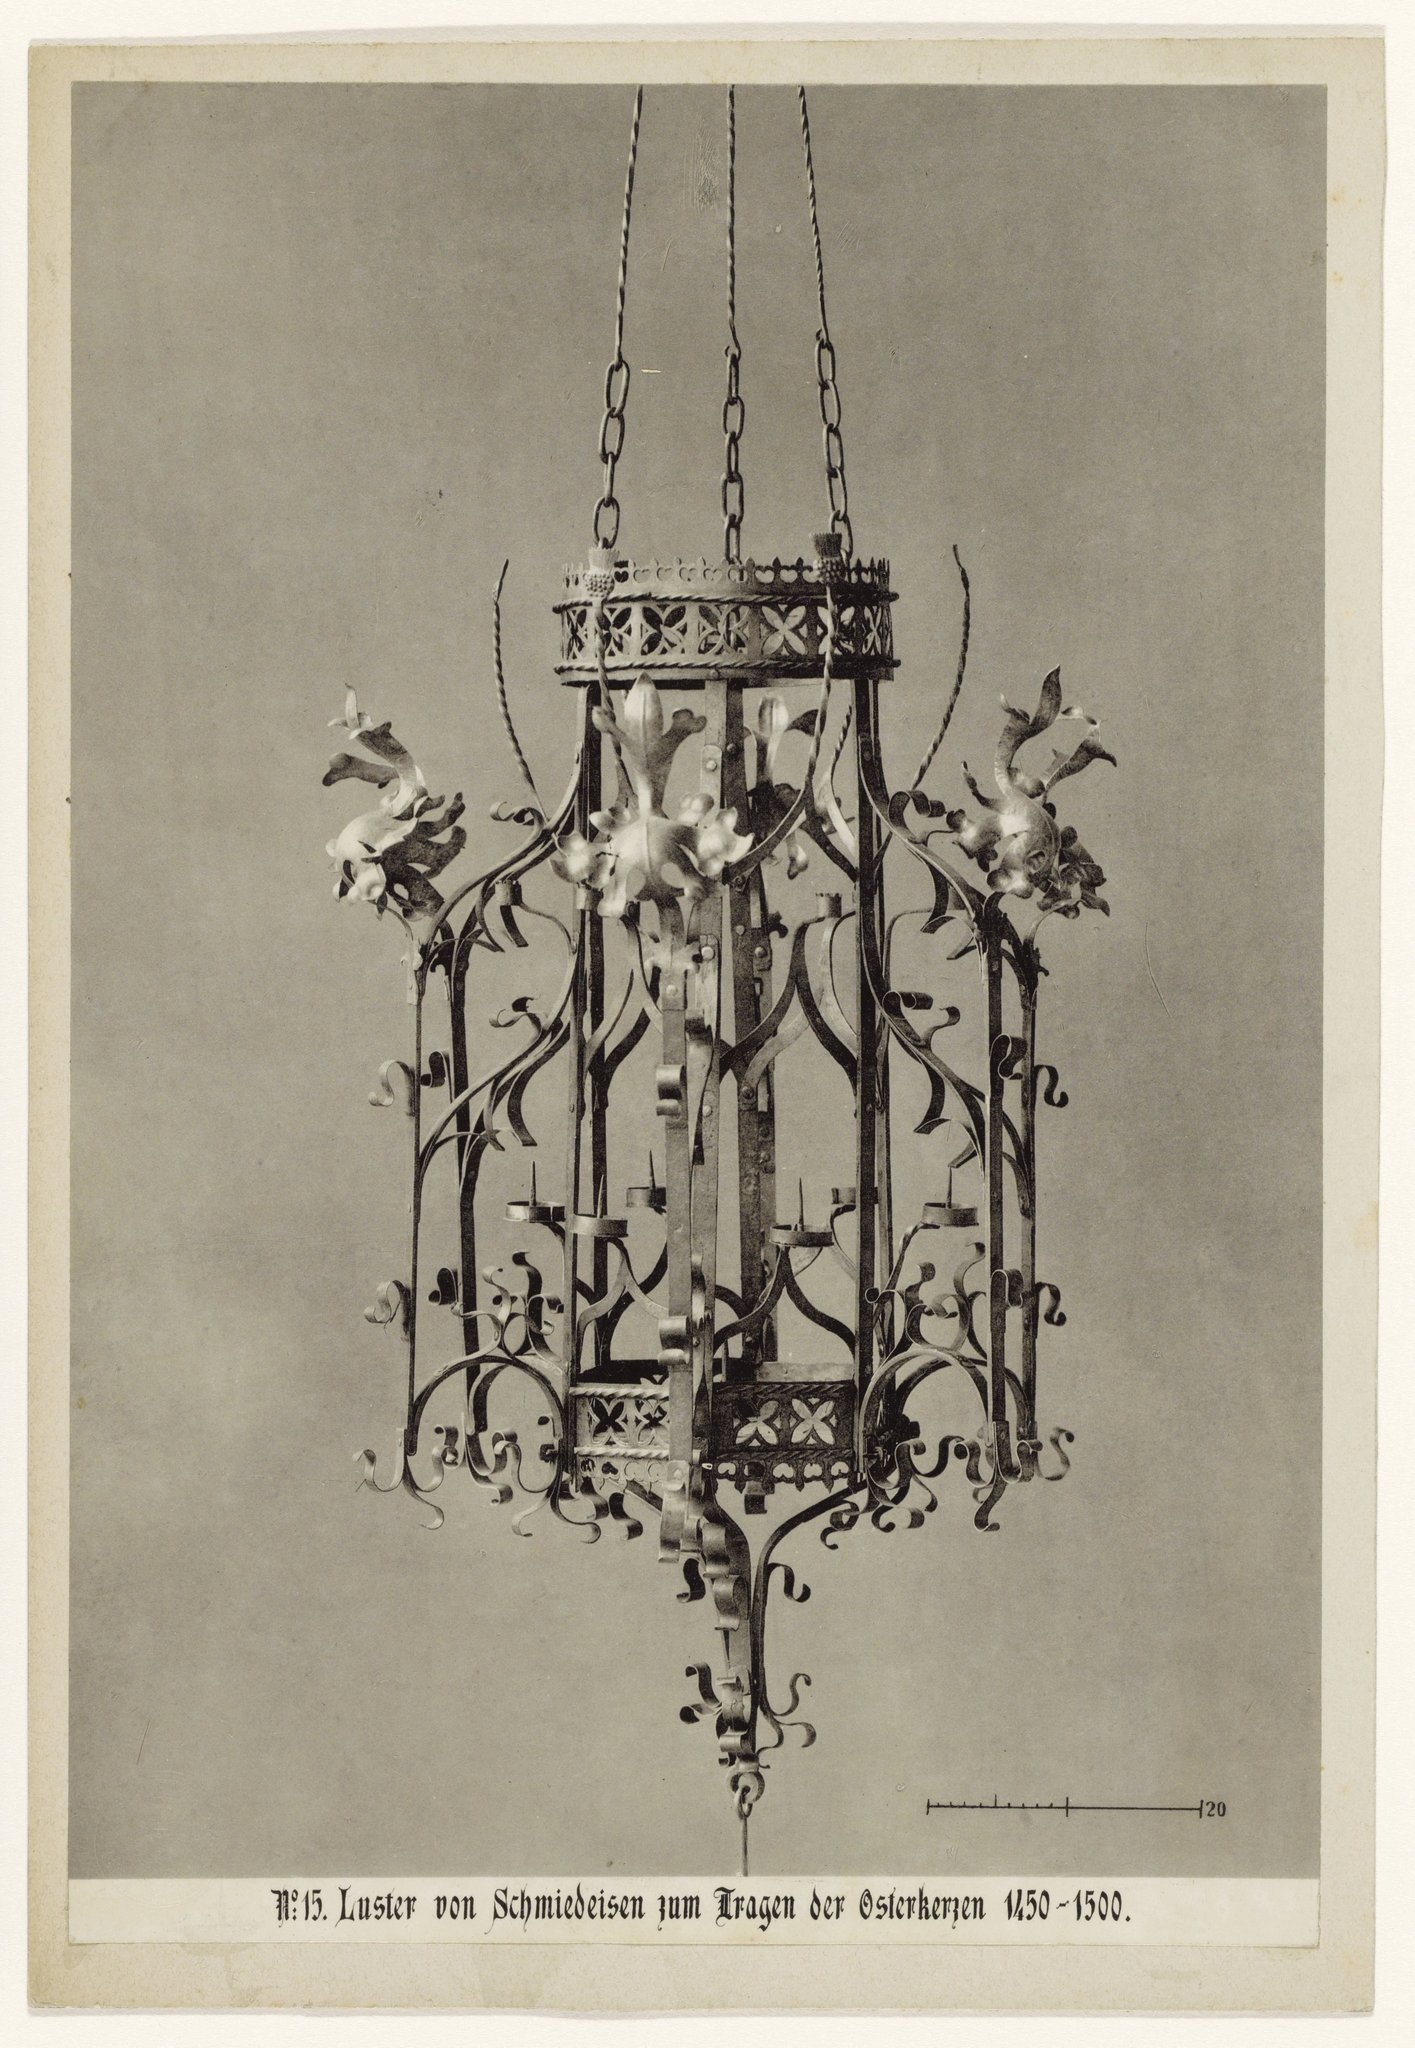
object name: photomechanical print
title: Kroonkandelaar van smeedijzer voor paaskaarsen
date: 1869-1887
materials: cardboard, paper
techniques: photograph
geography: munich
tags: ornament ~ candelabrum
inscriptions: check stamp: ‘Bayerisches National-Museum’, title: ‘No 15. Luster von Schmiedeisen zun Tragen der Osterkerzen 1450-1500.’